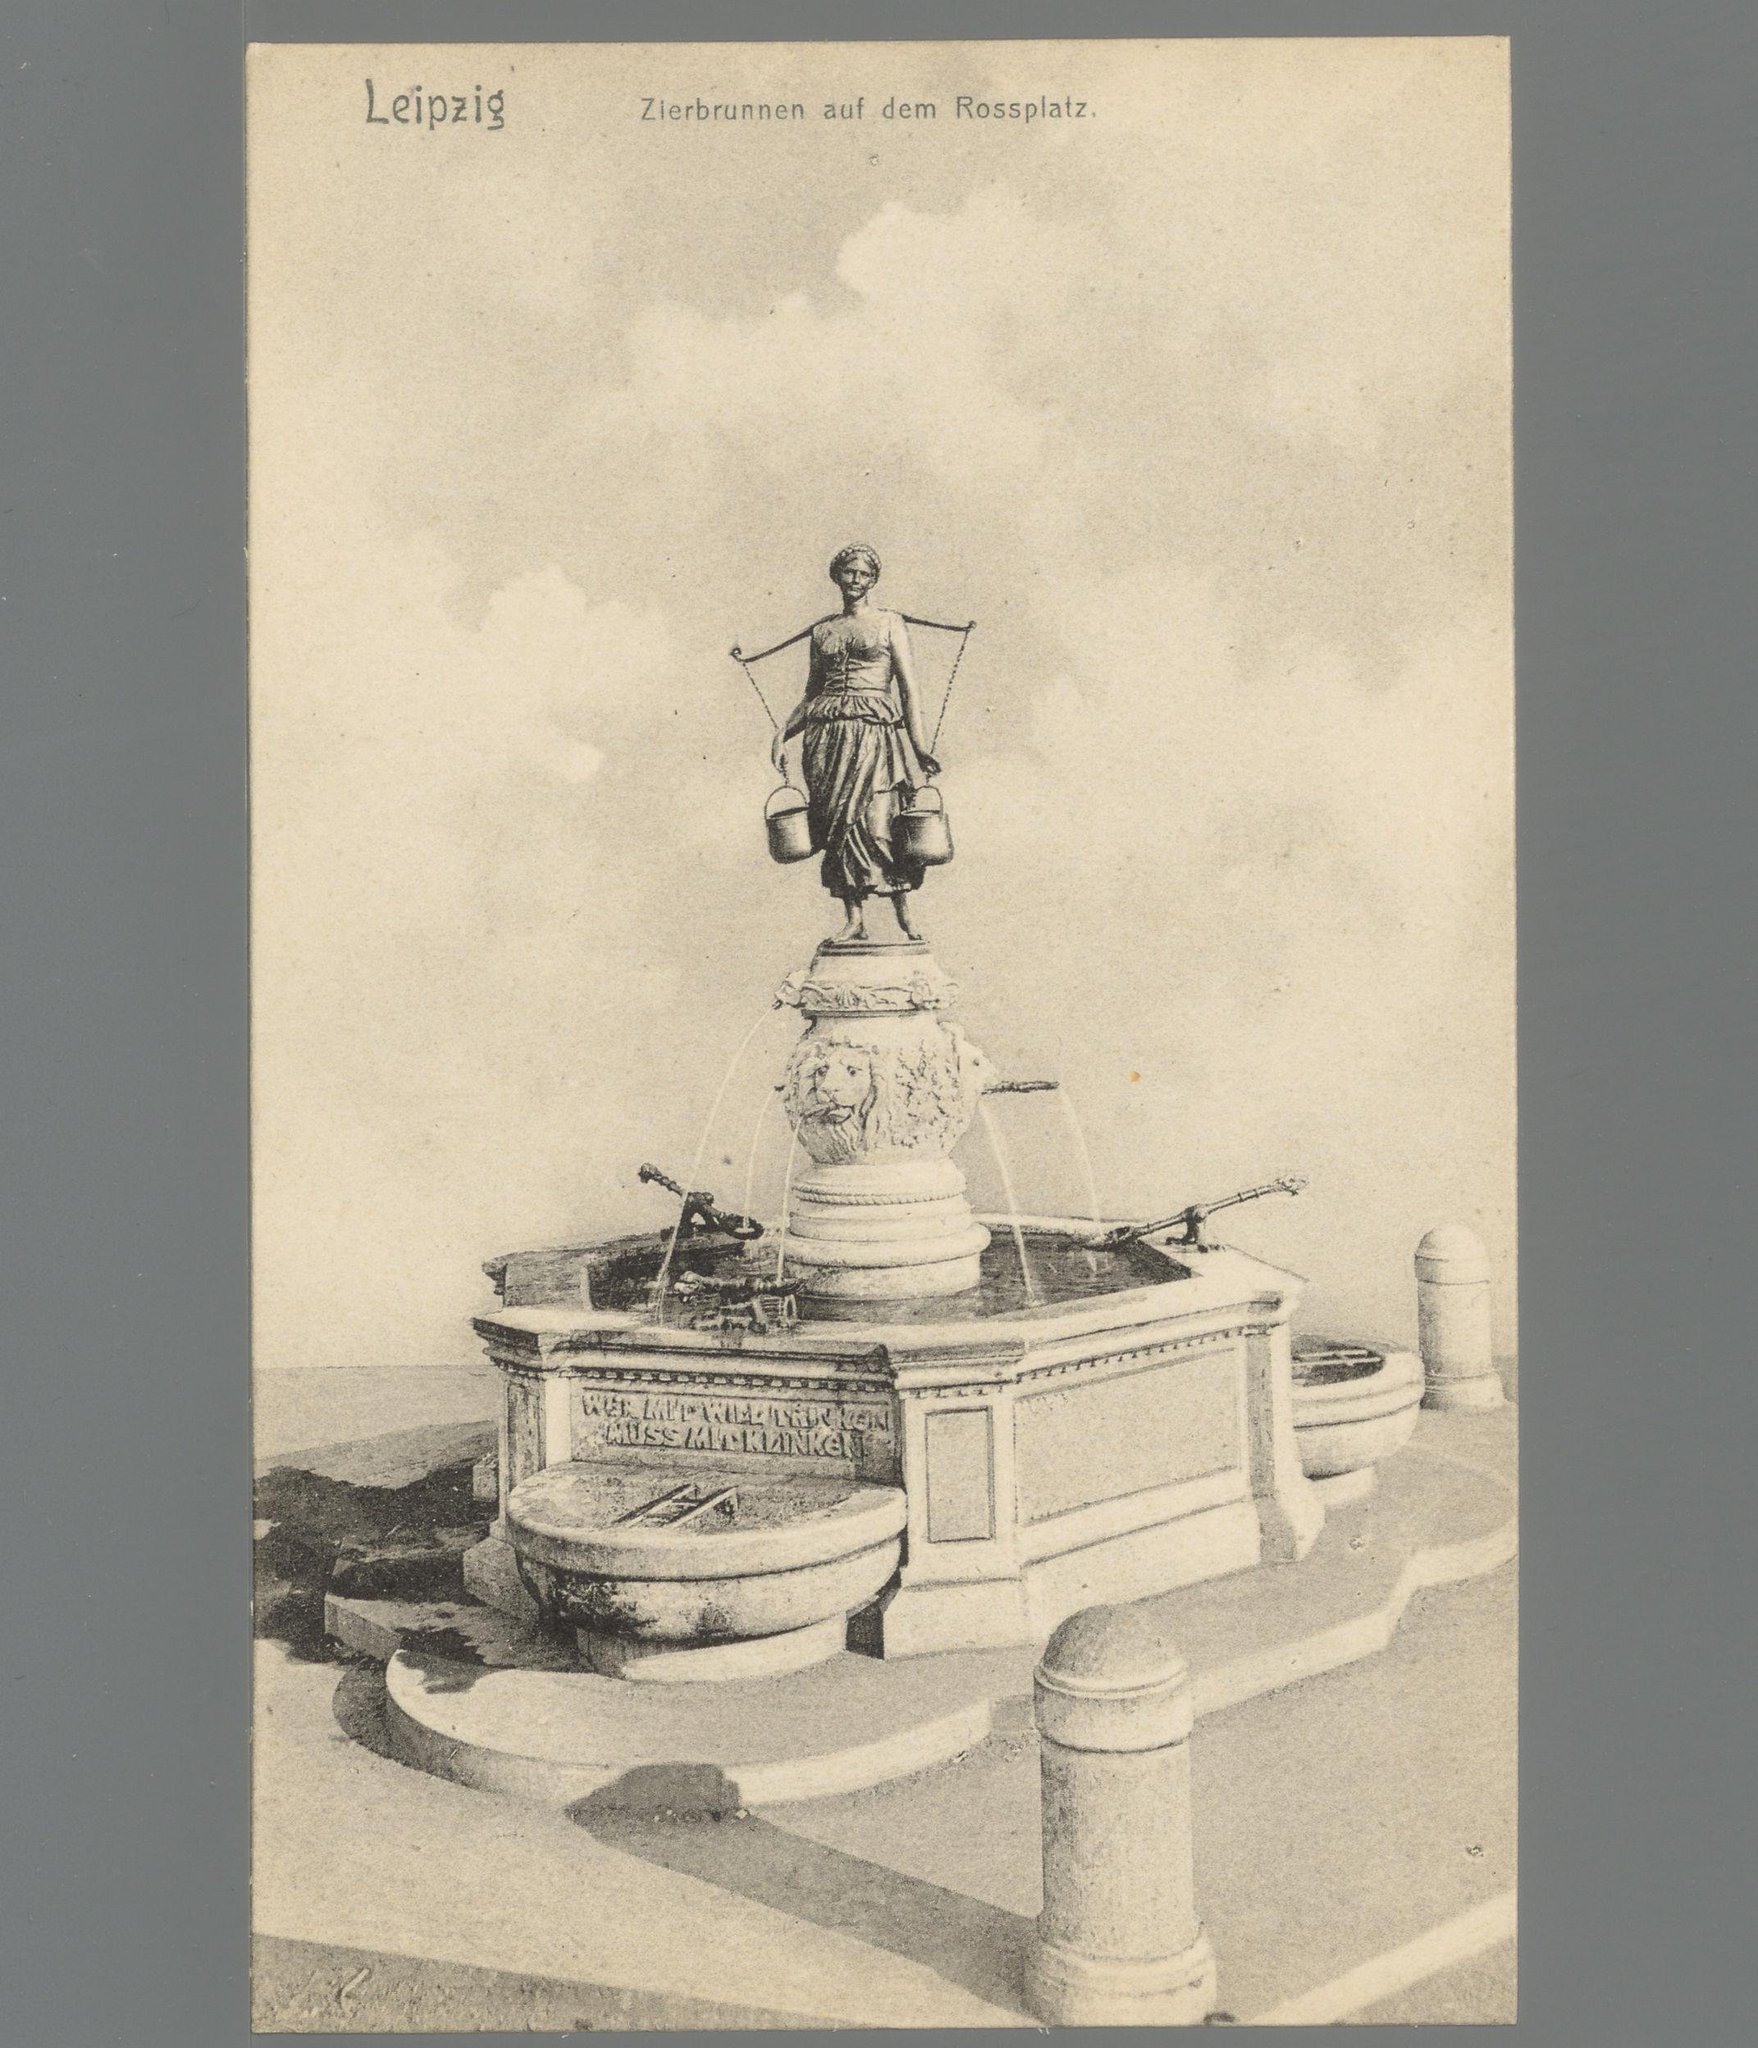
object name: photomechanical print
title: Leipzig. Zierbrunnen auf dem Rossplatz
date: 1908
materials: cardboard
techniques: photograph, writing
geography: hamburg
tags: ornamental fountain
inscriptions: date